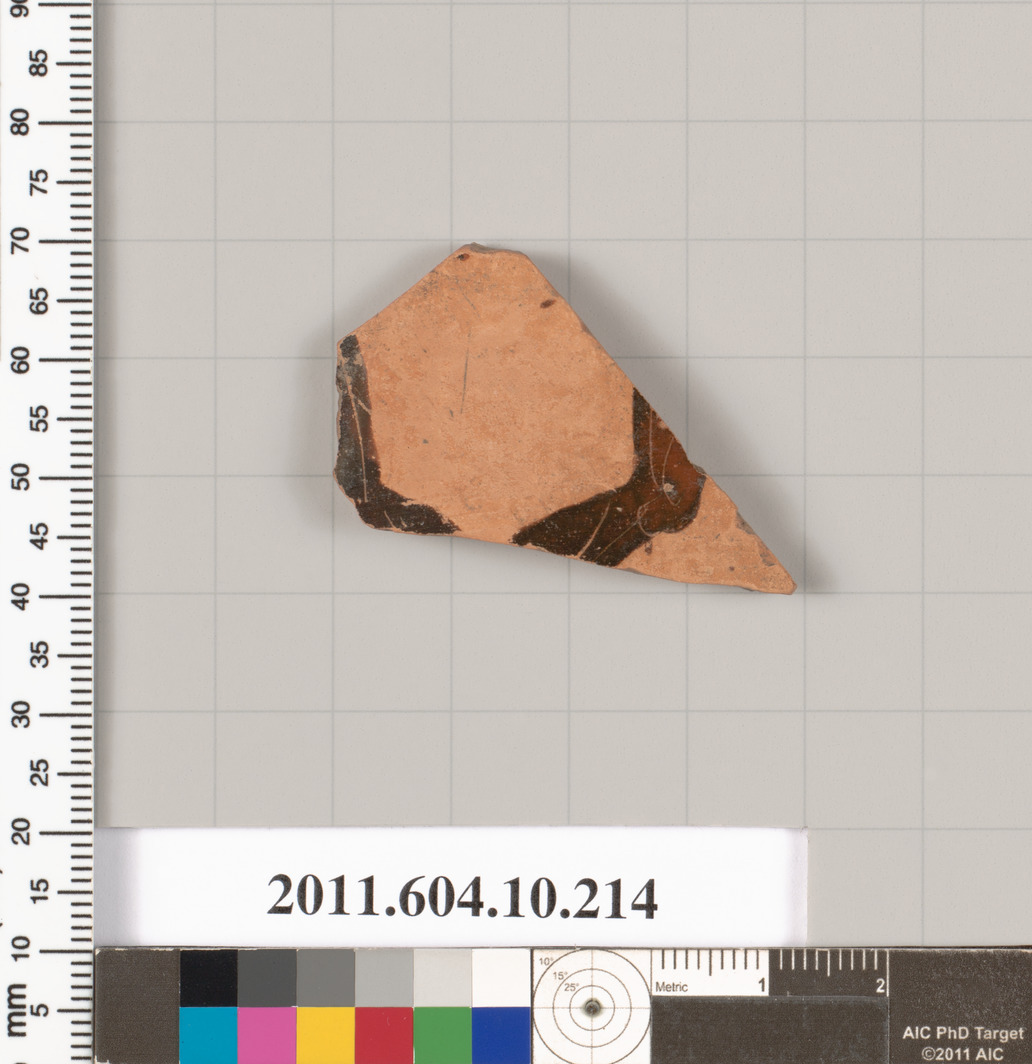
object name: amphora fragment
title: Terracotta fragment of an amphora (jar)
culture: etruscan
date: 600-501 BCE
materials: terracotta